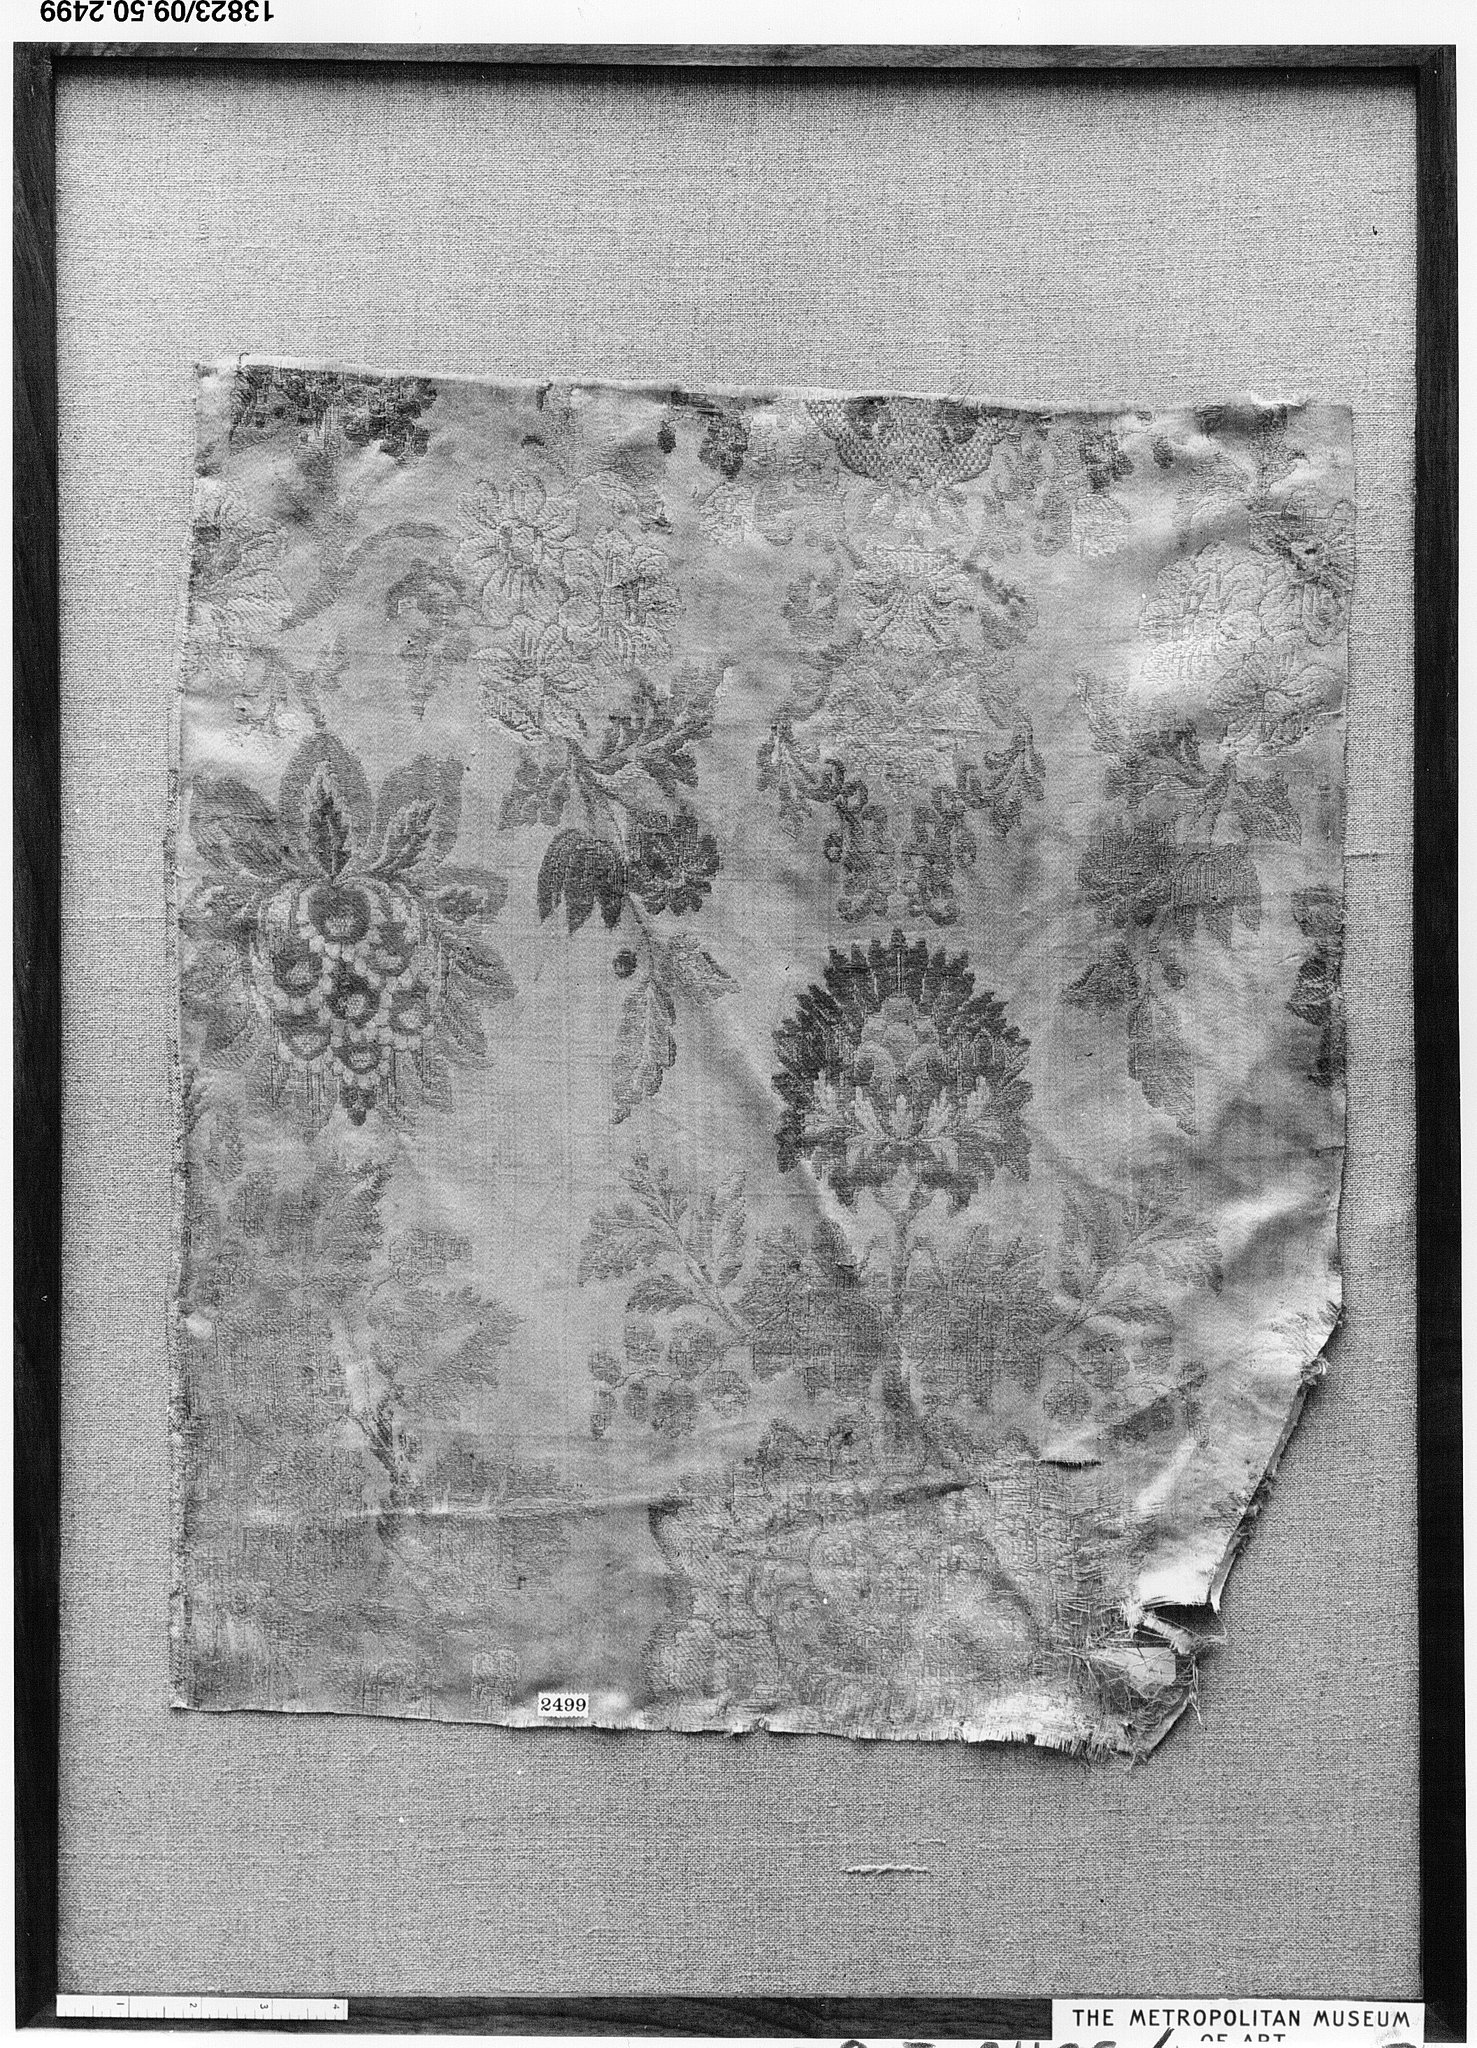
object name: piece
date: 1701-1800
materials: silk